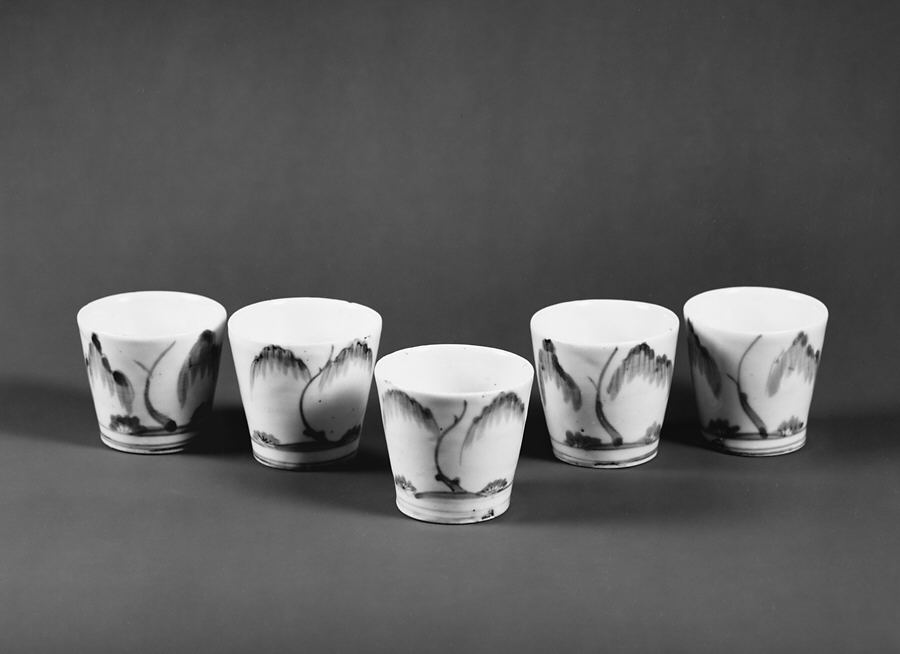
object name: soba cup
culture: japanese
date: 1667-1733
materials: porcelain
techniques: underglaze